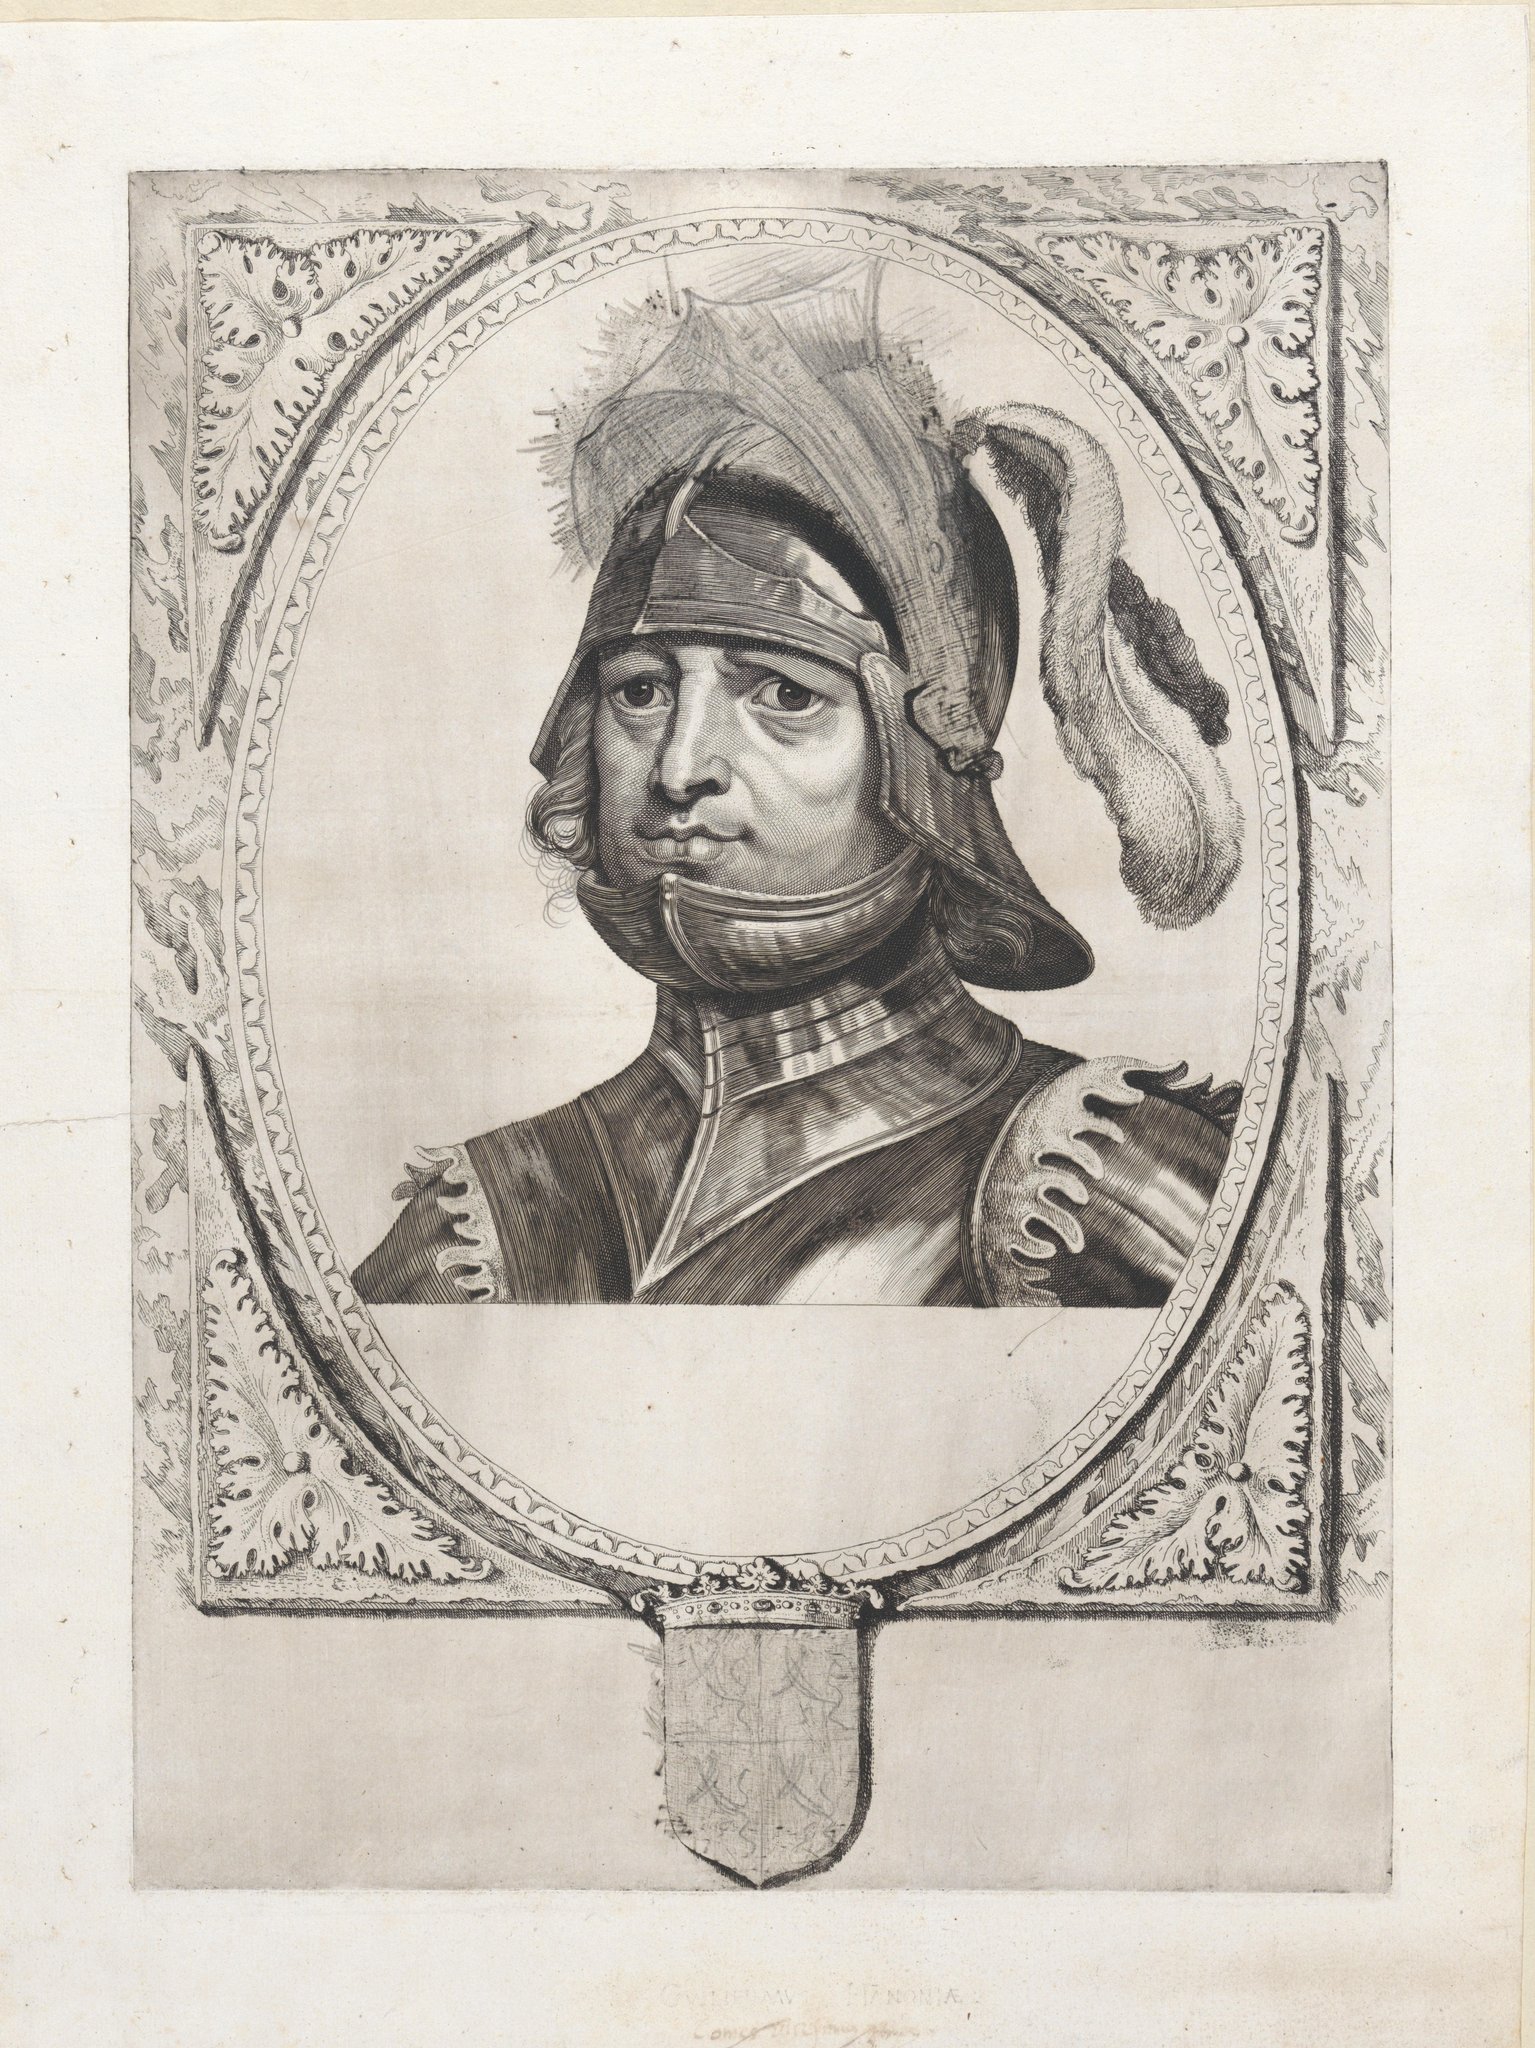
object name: print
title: Portret van Willem IV, graaf van Holland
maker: cornelis visscher (ii)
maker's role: draughtsman, painter, print maker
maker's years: 1628-1658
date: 1650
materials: paper, pencil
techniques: engraving, etching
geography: haarlem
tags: willem iv (graaf van holland), helmet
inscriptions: collector's mark: Lugt 240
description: Proefdruk van de drieentwintigste prent uit de serie 'Graven en gravinnen van Holland, Zeeland en West-Friesland', bestaande uit 38 prenten.